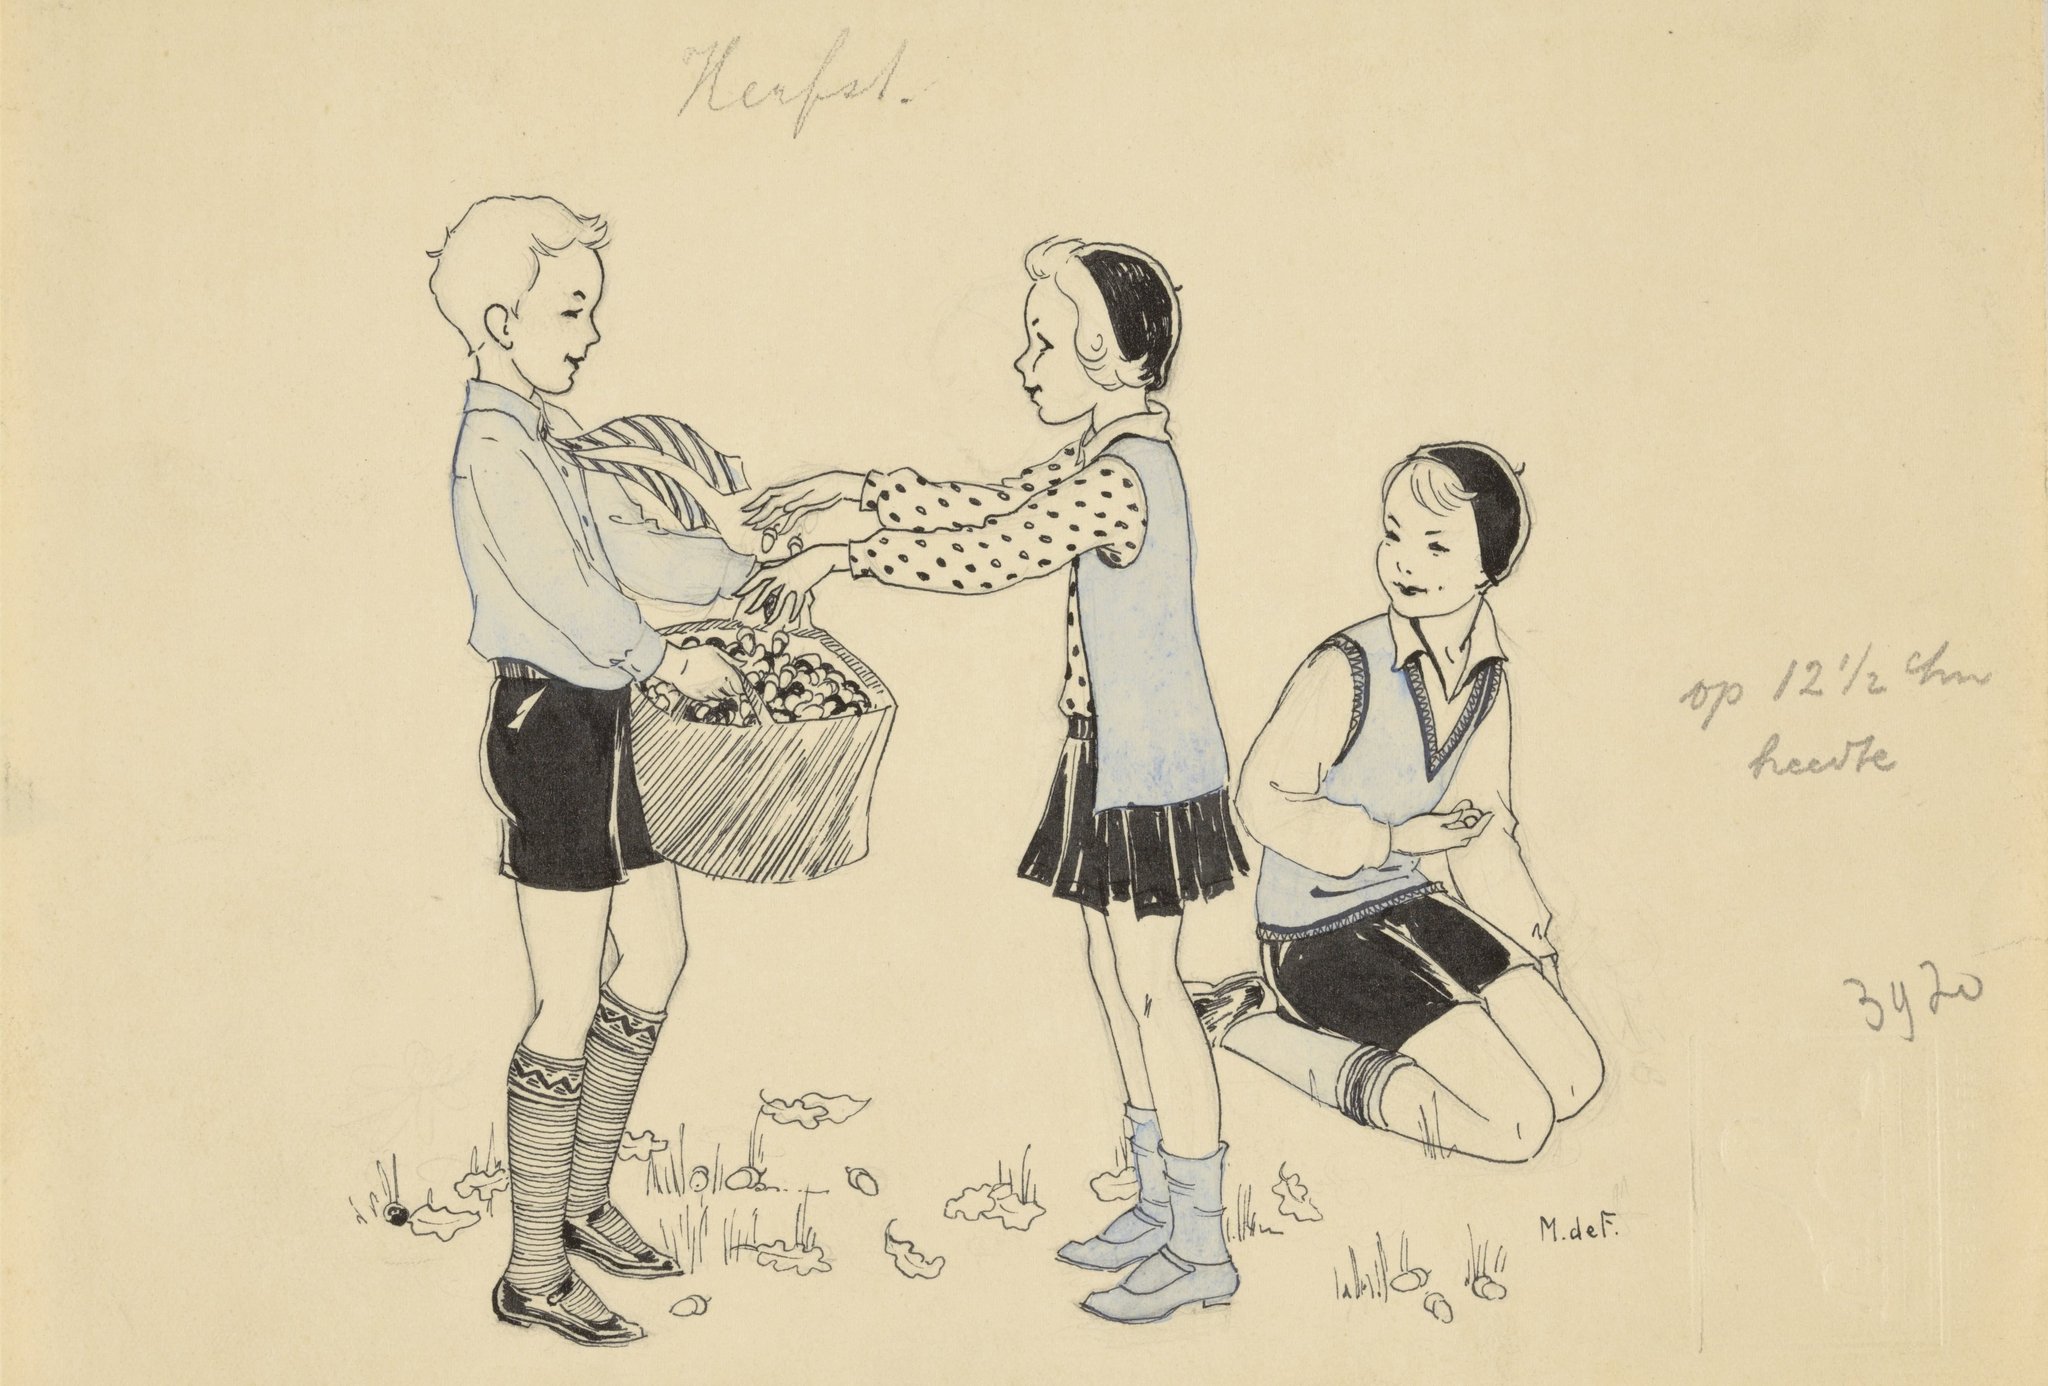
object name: boekillustratie ontwerp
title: Drie kinderen die eikels rapen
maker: miep de feijter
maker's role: draughtsman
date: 1928-1941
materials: ink, paper, pencil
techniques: brush, pen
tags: carrying something in basket, bag, rucksack, etc., autumn landscape; landscape symbolizing autumn (the four seasons of the year), fruits: acorn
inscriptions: signature: ‘M. de F.’, collector's mark: Lugt 2228a, :, annotation: ‘Herfst.’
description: Een meisje gooit eikels in een mand die door een jongen wordt vastgehouden. Op de grond zit een tweede jongen met eikels in de hand. Op de grond liggen eikels en bladeren. Verso een potloodschets.